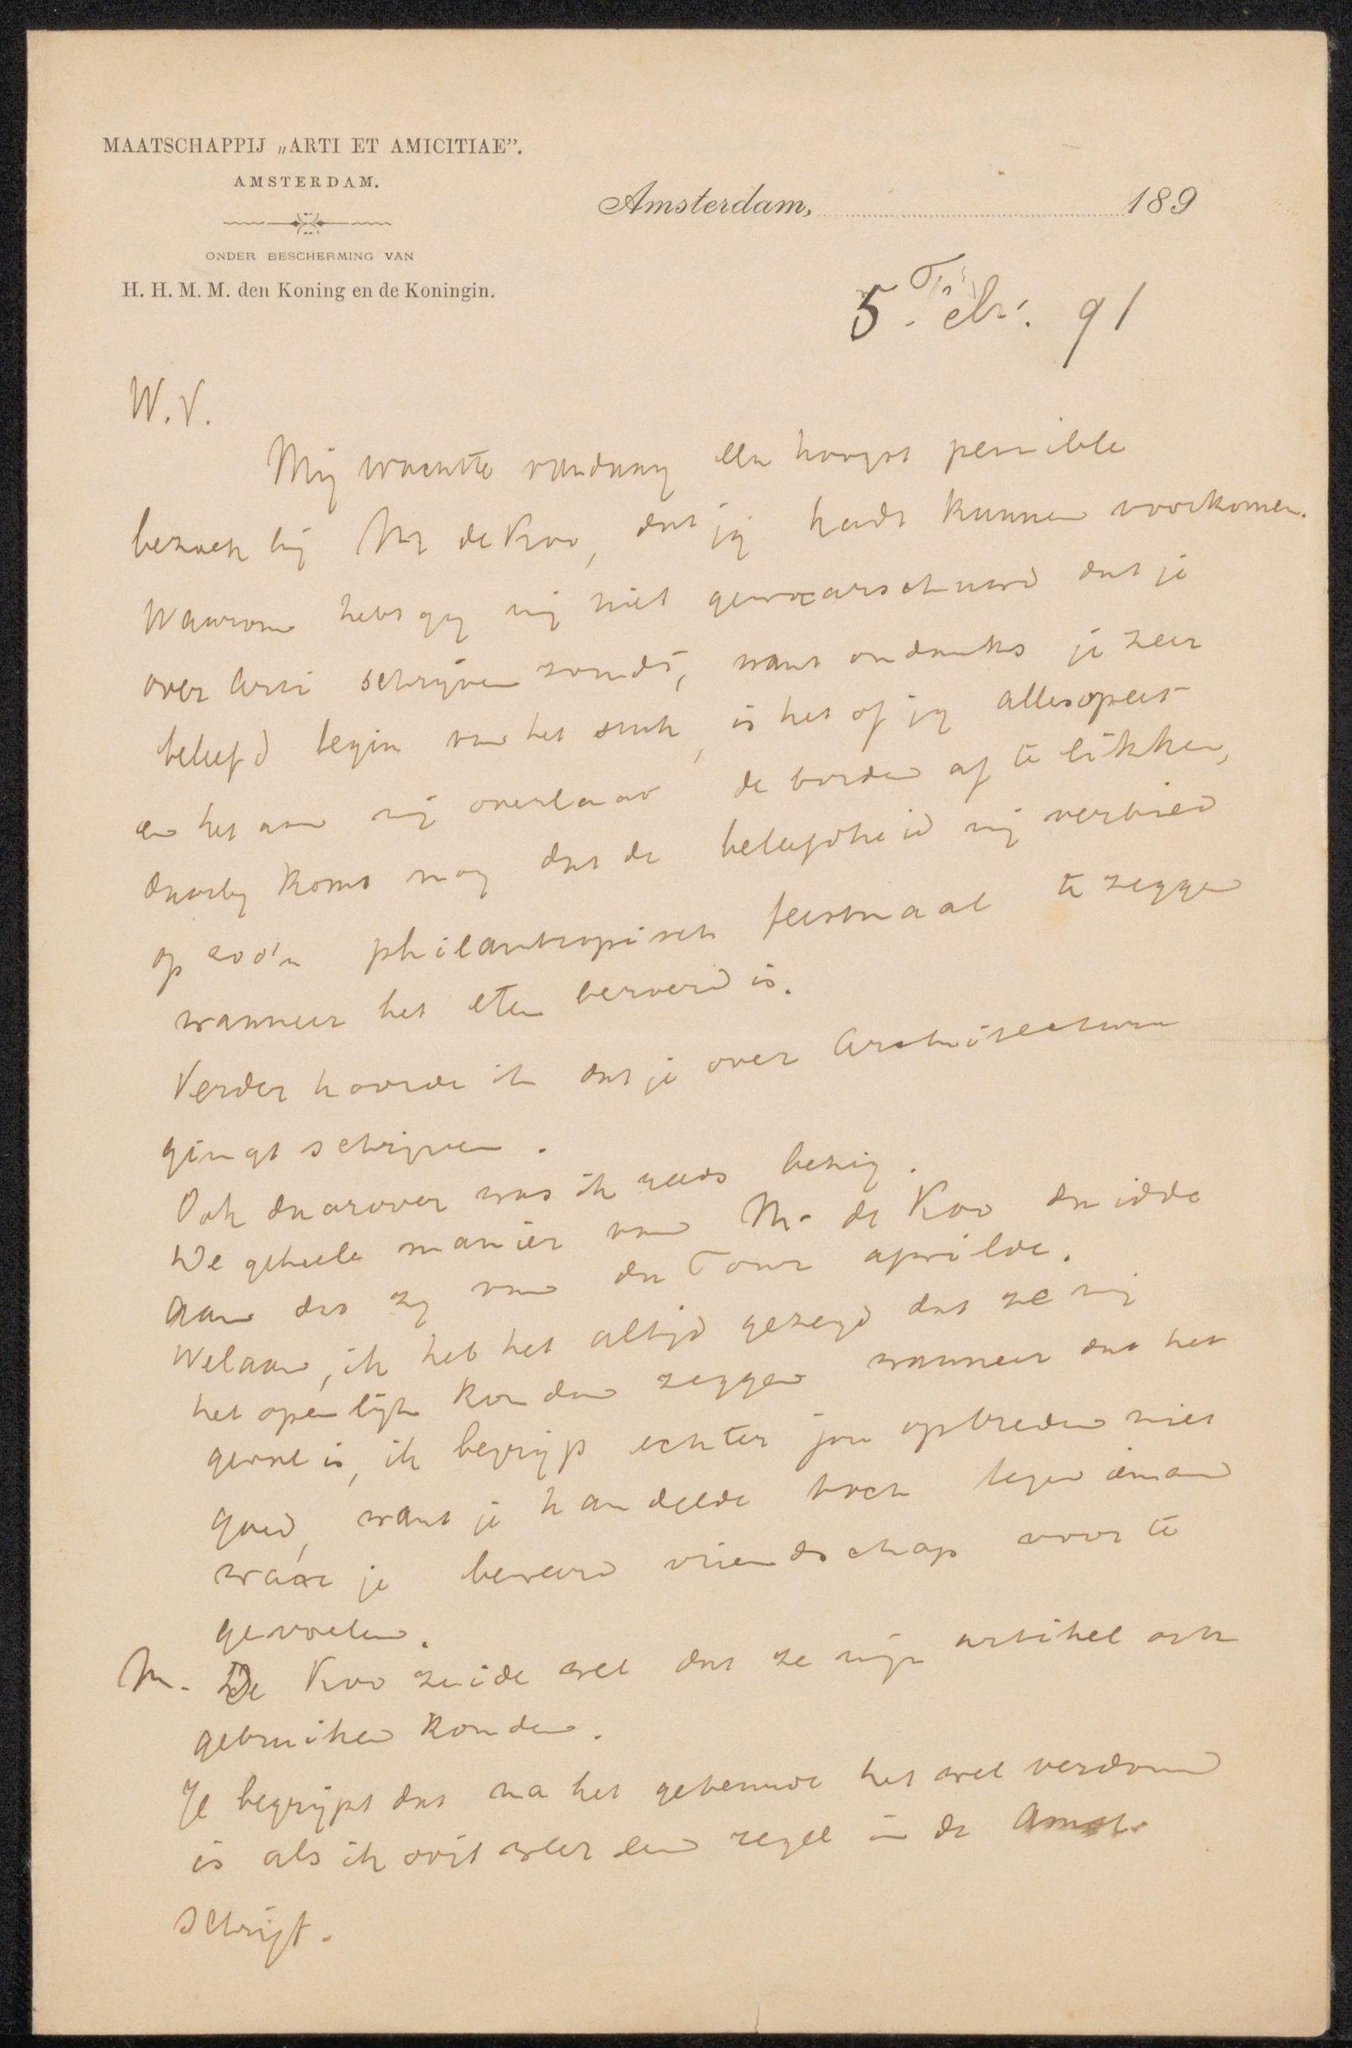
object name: letter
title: Brief aan Jan Veth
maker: richard nicolaüs roland holst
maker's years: 1868-1938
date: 1891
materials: ink, paper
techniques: pen, printing, writing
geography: amsterdam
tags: dordrecht, painter, print maker, draughtsman, designer, jan veth, liège, johannes de koo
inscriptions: collector's mark: ‘RPK’